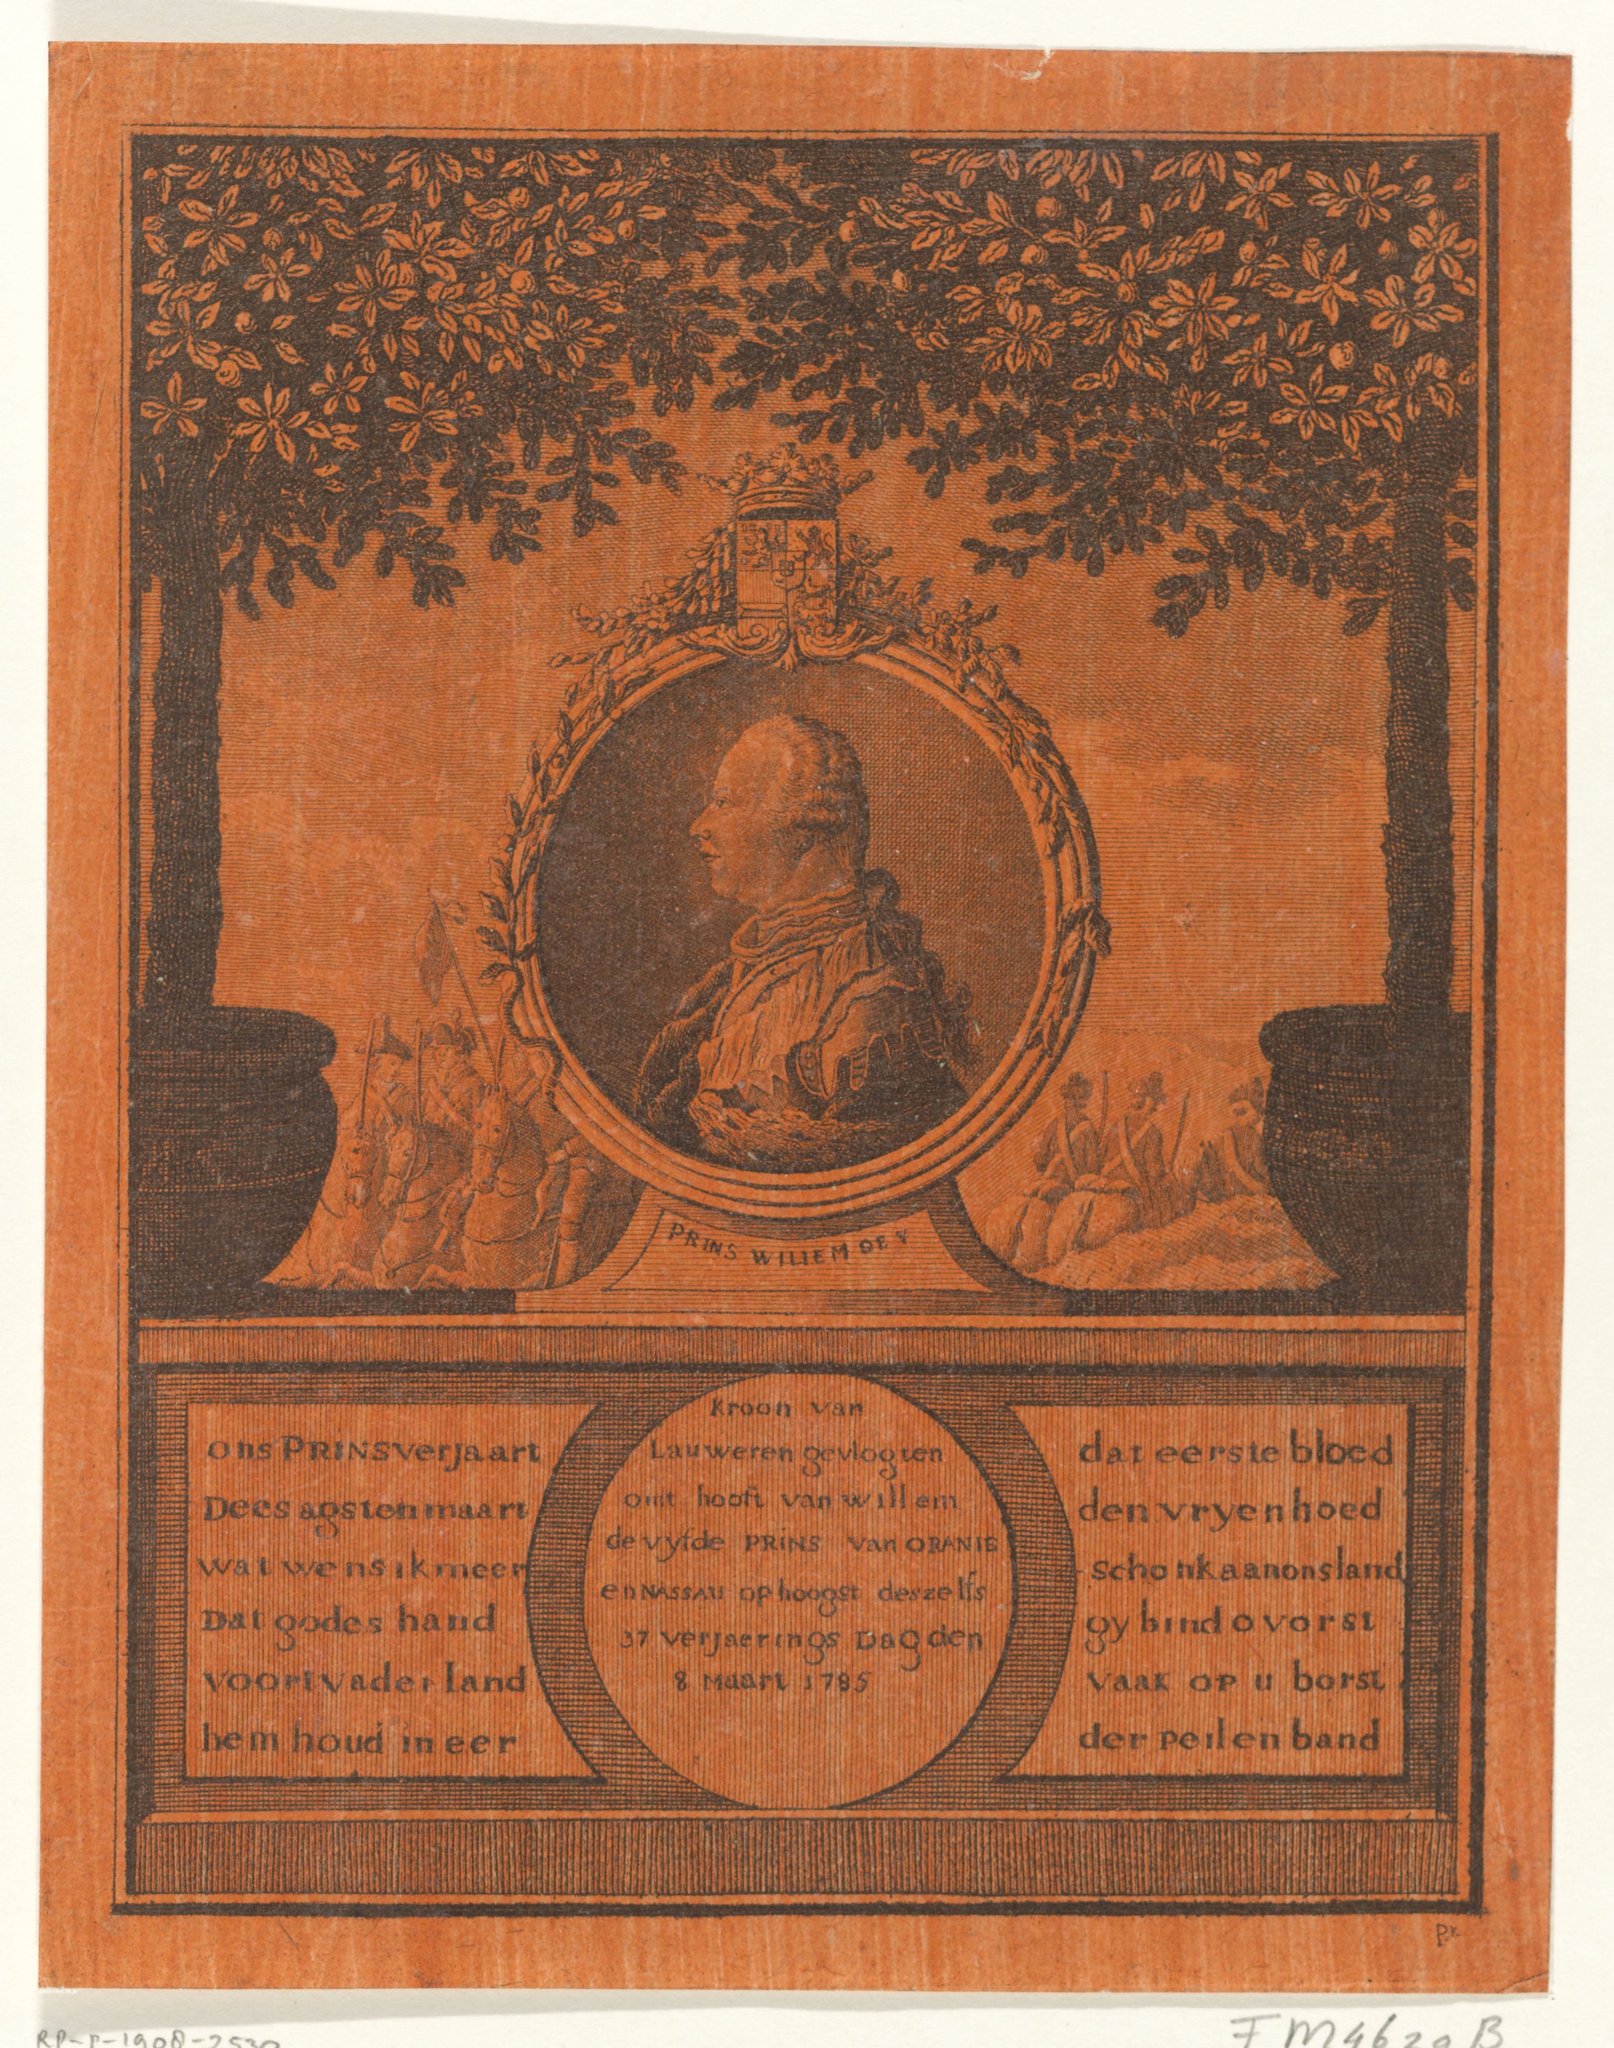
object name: print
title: Portret van prins Willem V, 1785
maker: monogrammist pk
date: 1785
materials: paper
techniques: etching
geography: northern netherlands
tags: the hague, william v (prince of orange), patriots (1780-1795)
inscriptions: collector's mark: Lugt 2228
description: Portret van prins Willem V ter gelegenheid van zijn 37ste verjaardag op 8 maart 1785. Portret in profiel naar links in rond medaillon omvlochten met lauwertakken, links en rechts potten met Oranjebomen. Onder het portret een zesregelig vers.